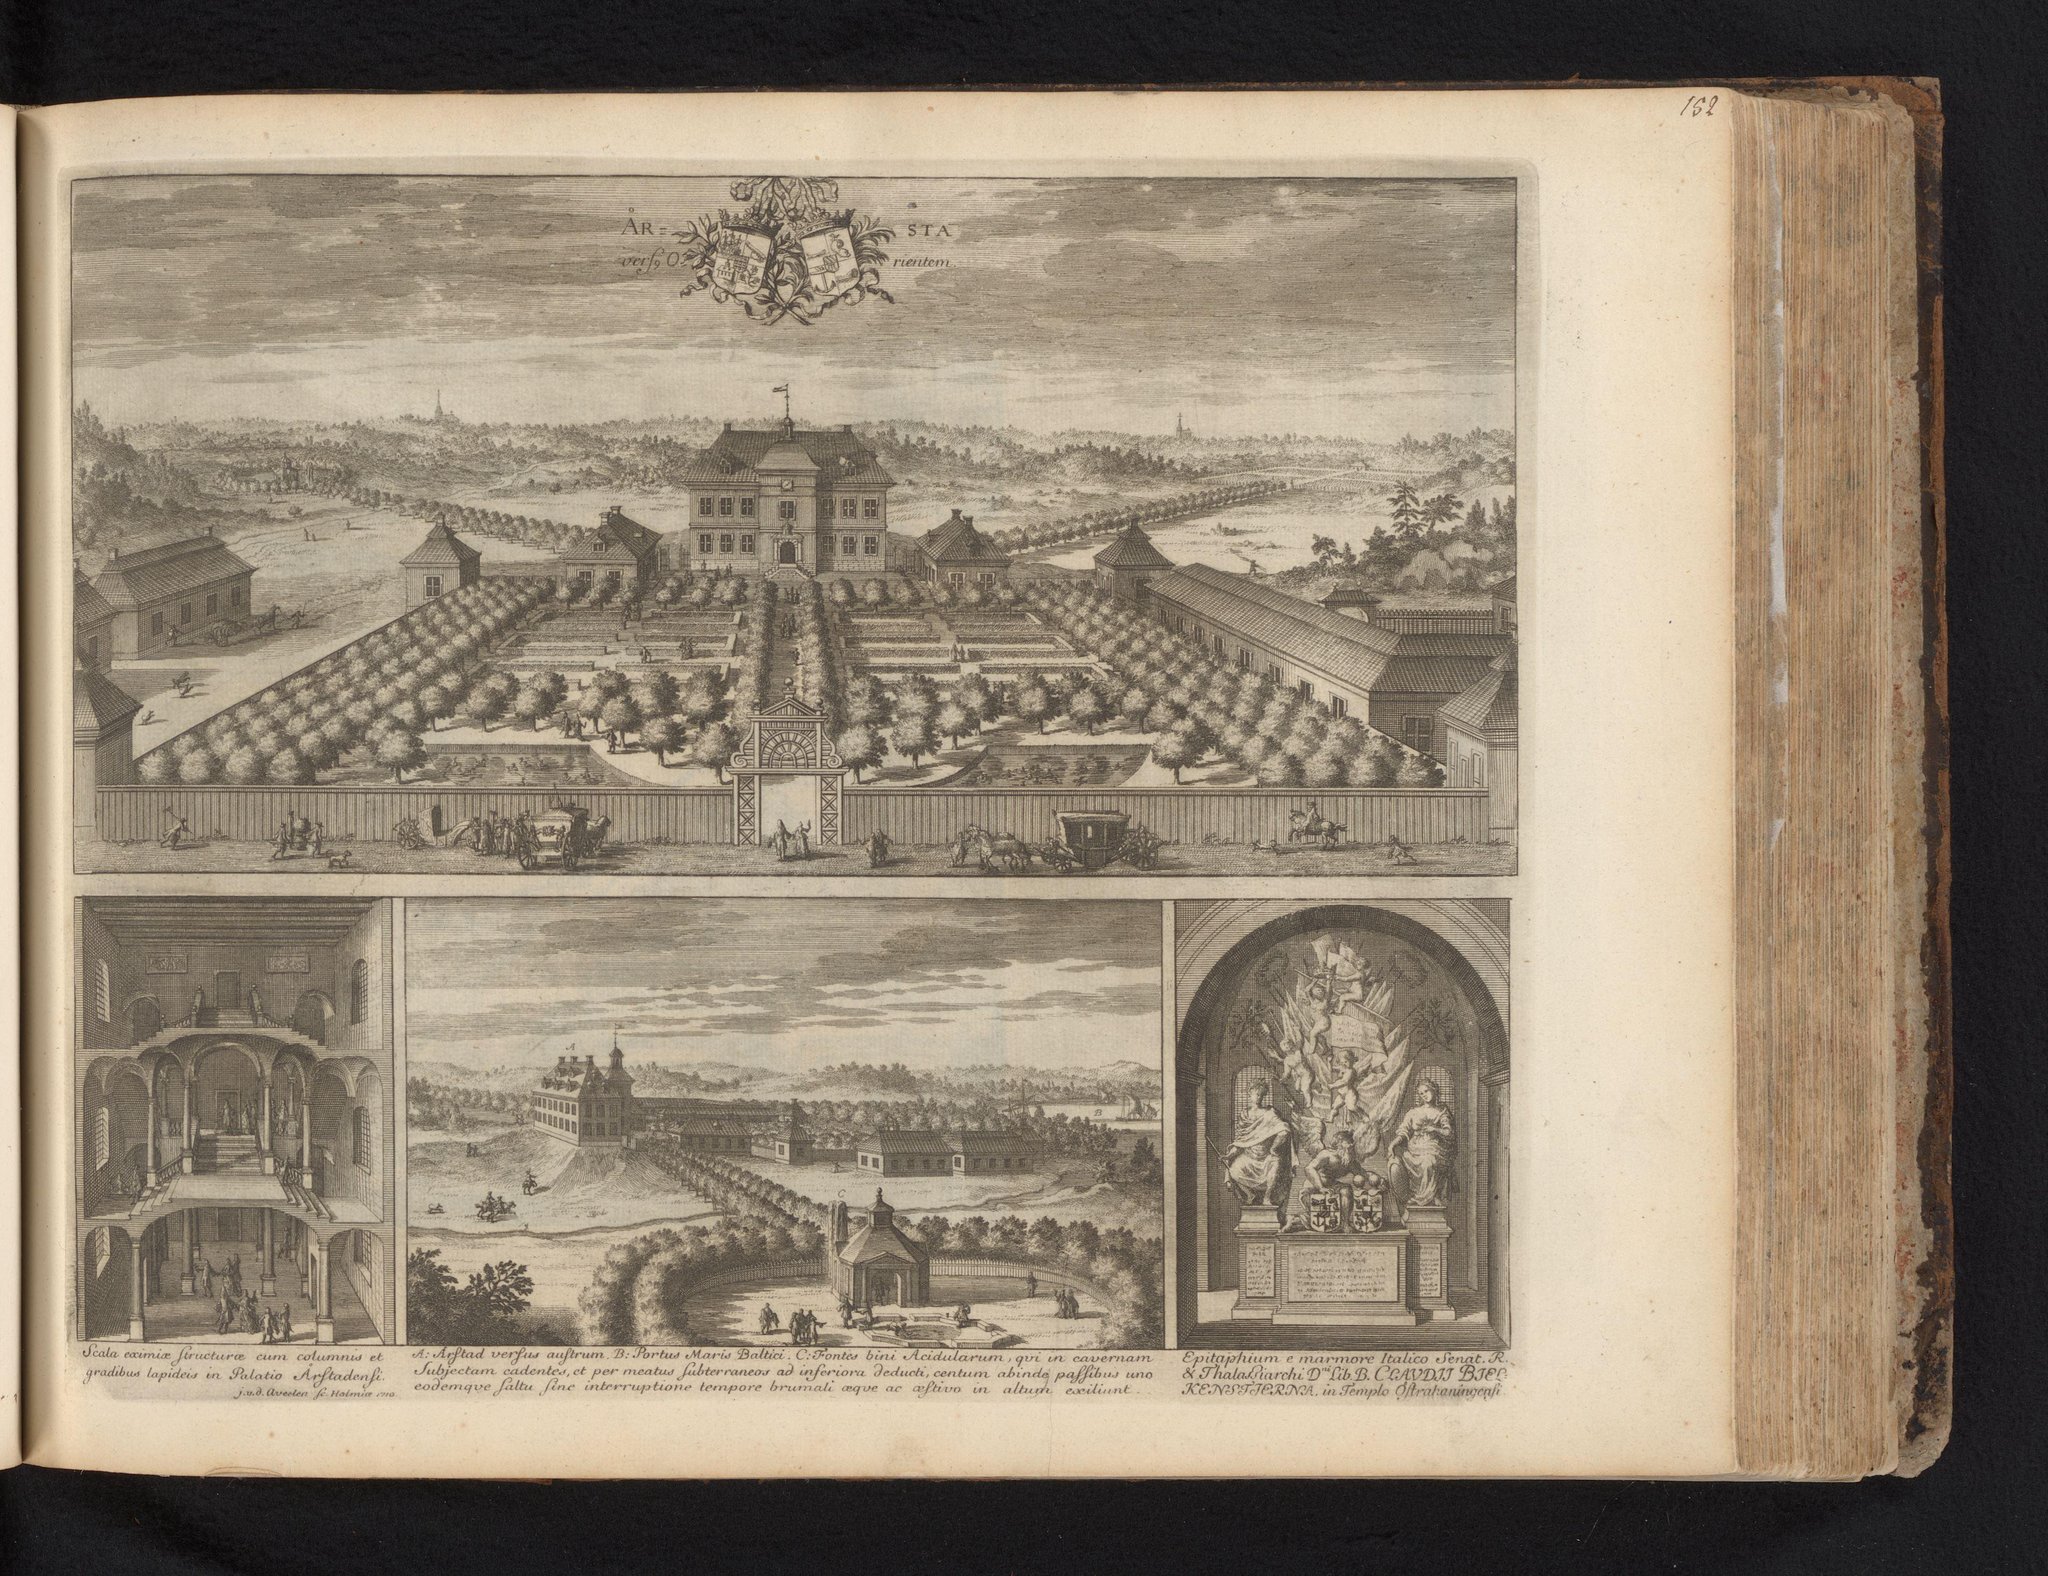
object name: album leaf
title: Åhrsta versus Orientem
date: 1710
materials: paper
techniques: etching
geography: stockholm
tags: housing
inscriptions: date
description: Kungliga Biblioteket, 'Suecia': http://www.kb.se/samlingarna/Kartor-bilder/Suecia-antiqua/ (geraadpleegd november 2016).